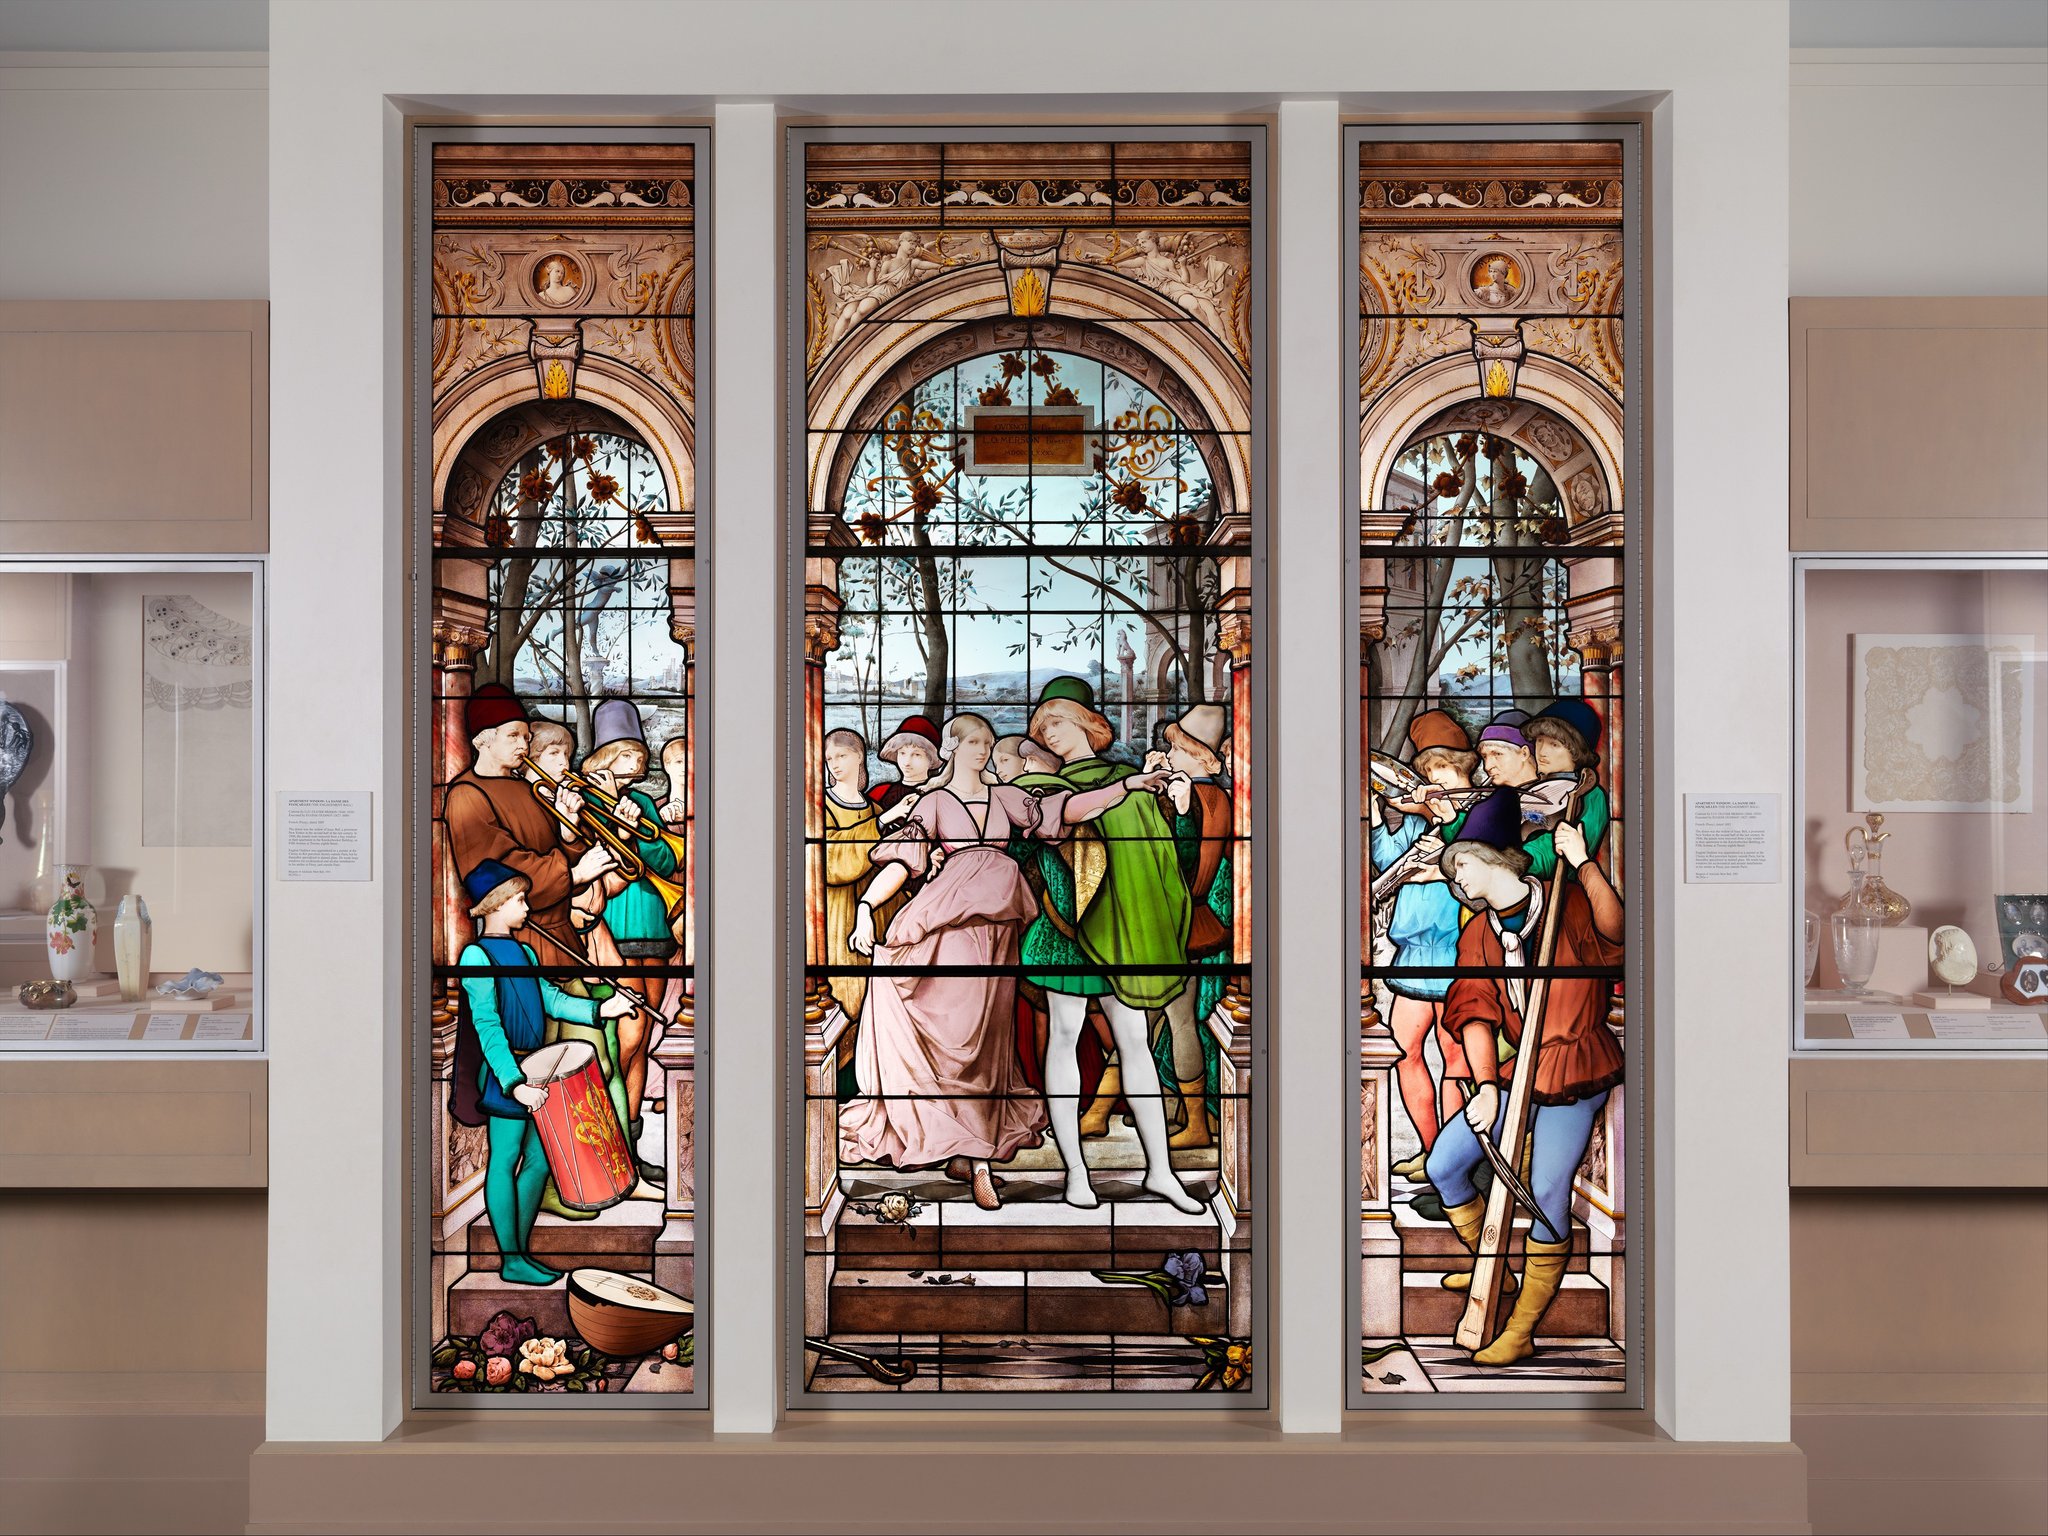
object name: window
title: La Danse des Fiançailles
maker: luc-olivier merson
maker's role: designer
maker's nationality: french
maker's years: 1846-1920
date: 1885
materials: glass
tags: musical instruments,men,women,dancing,musicians